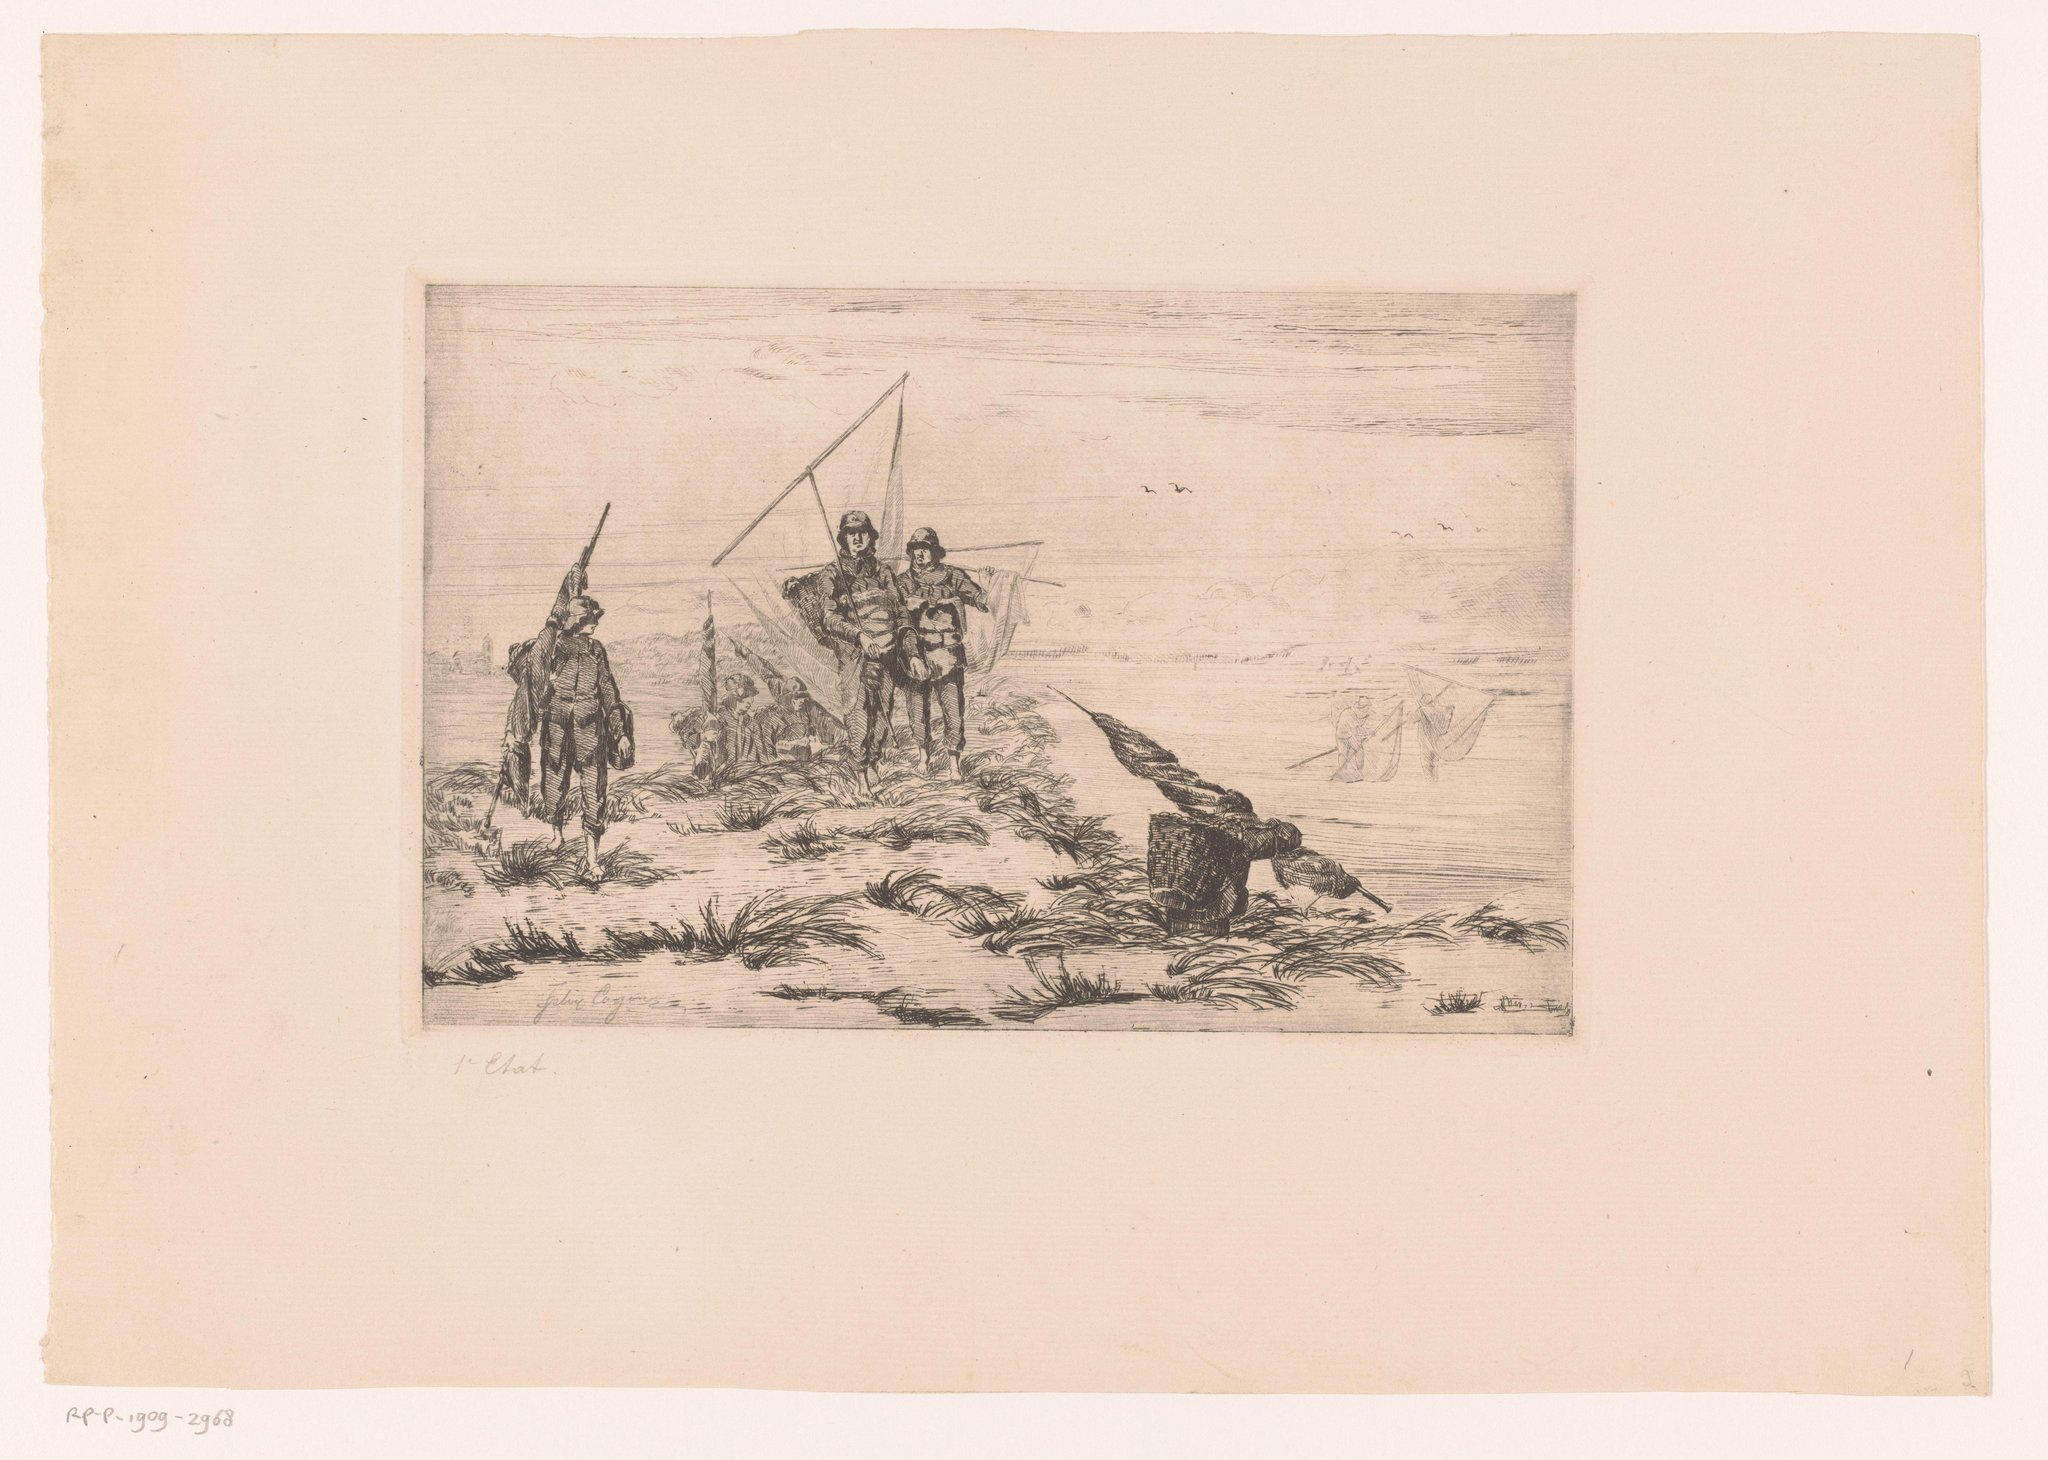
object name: print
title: Vissers met schepnetten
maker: félix cogen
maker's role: print maker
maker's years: 1838-1907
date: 1848-1907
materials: paper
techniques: drypoint, etching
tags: fishing net, fisherman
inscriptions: collector's mark